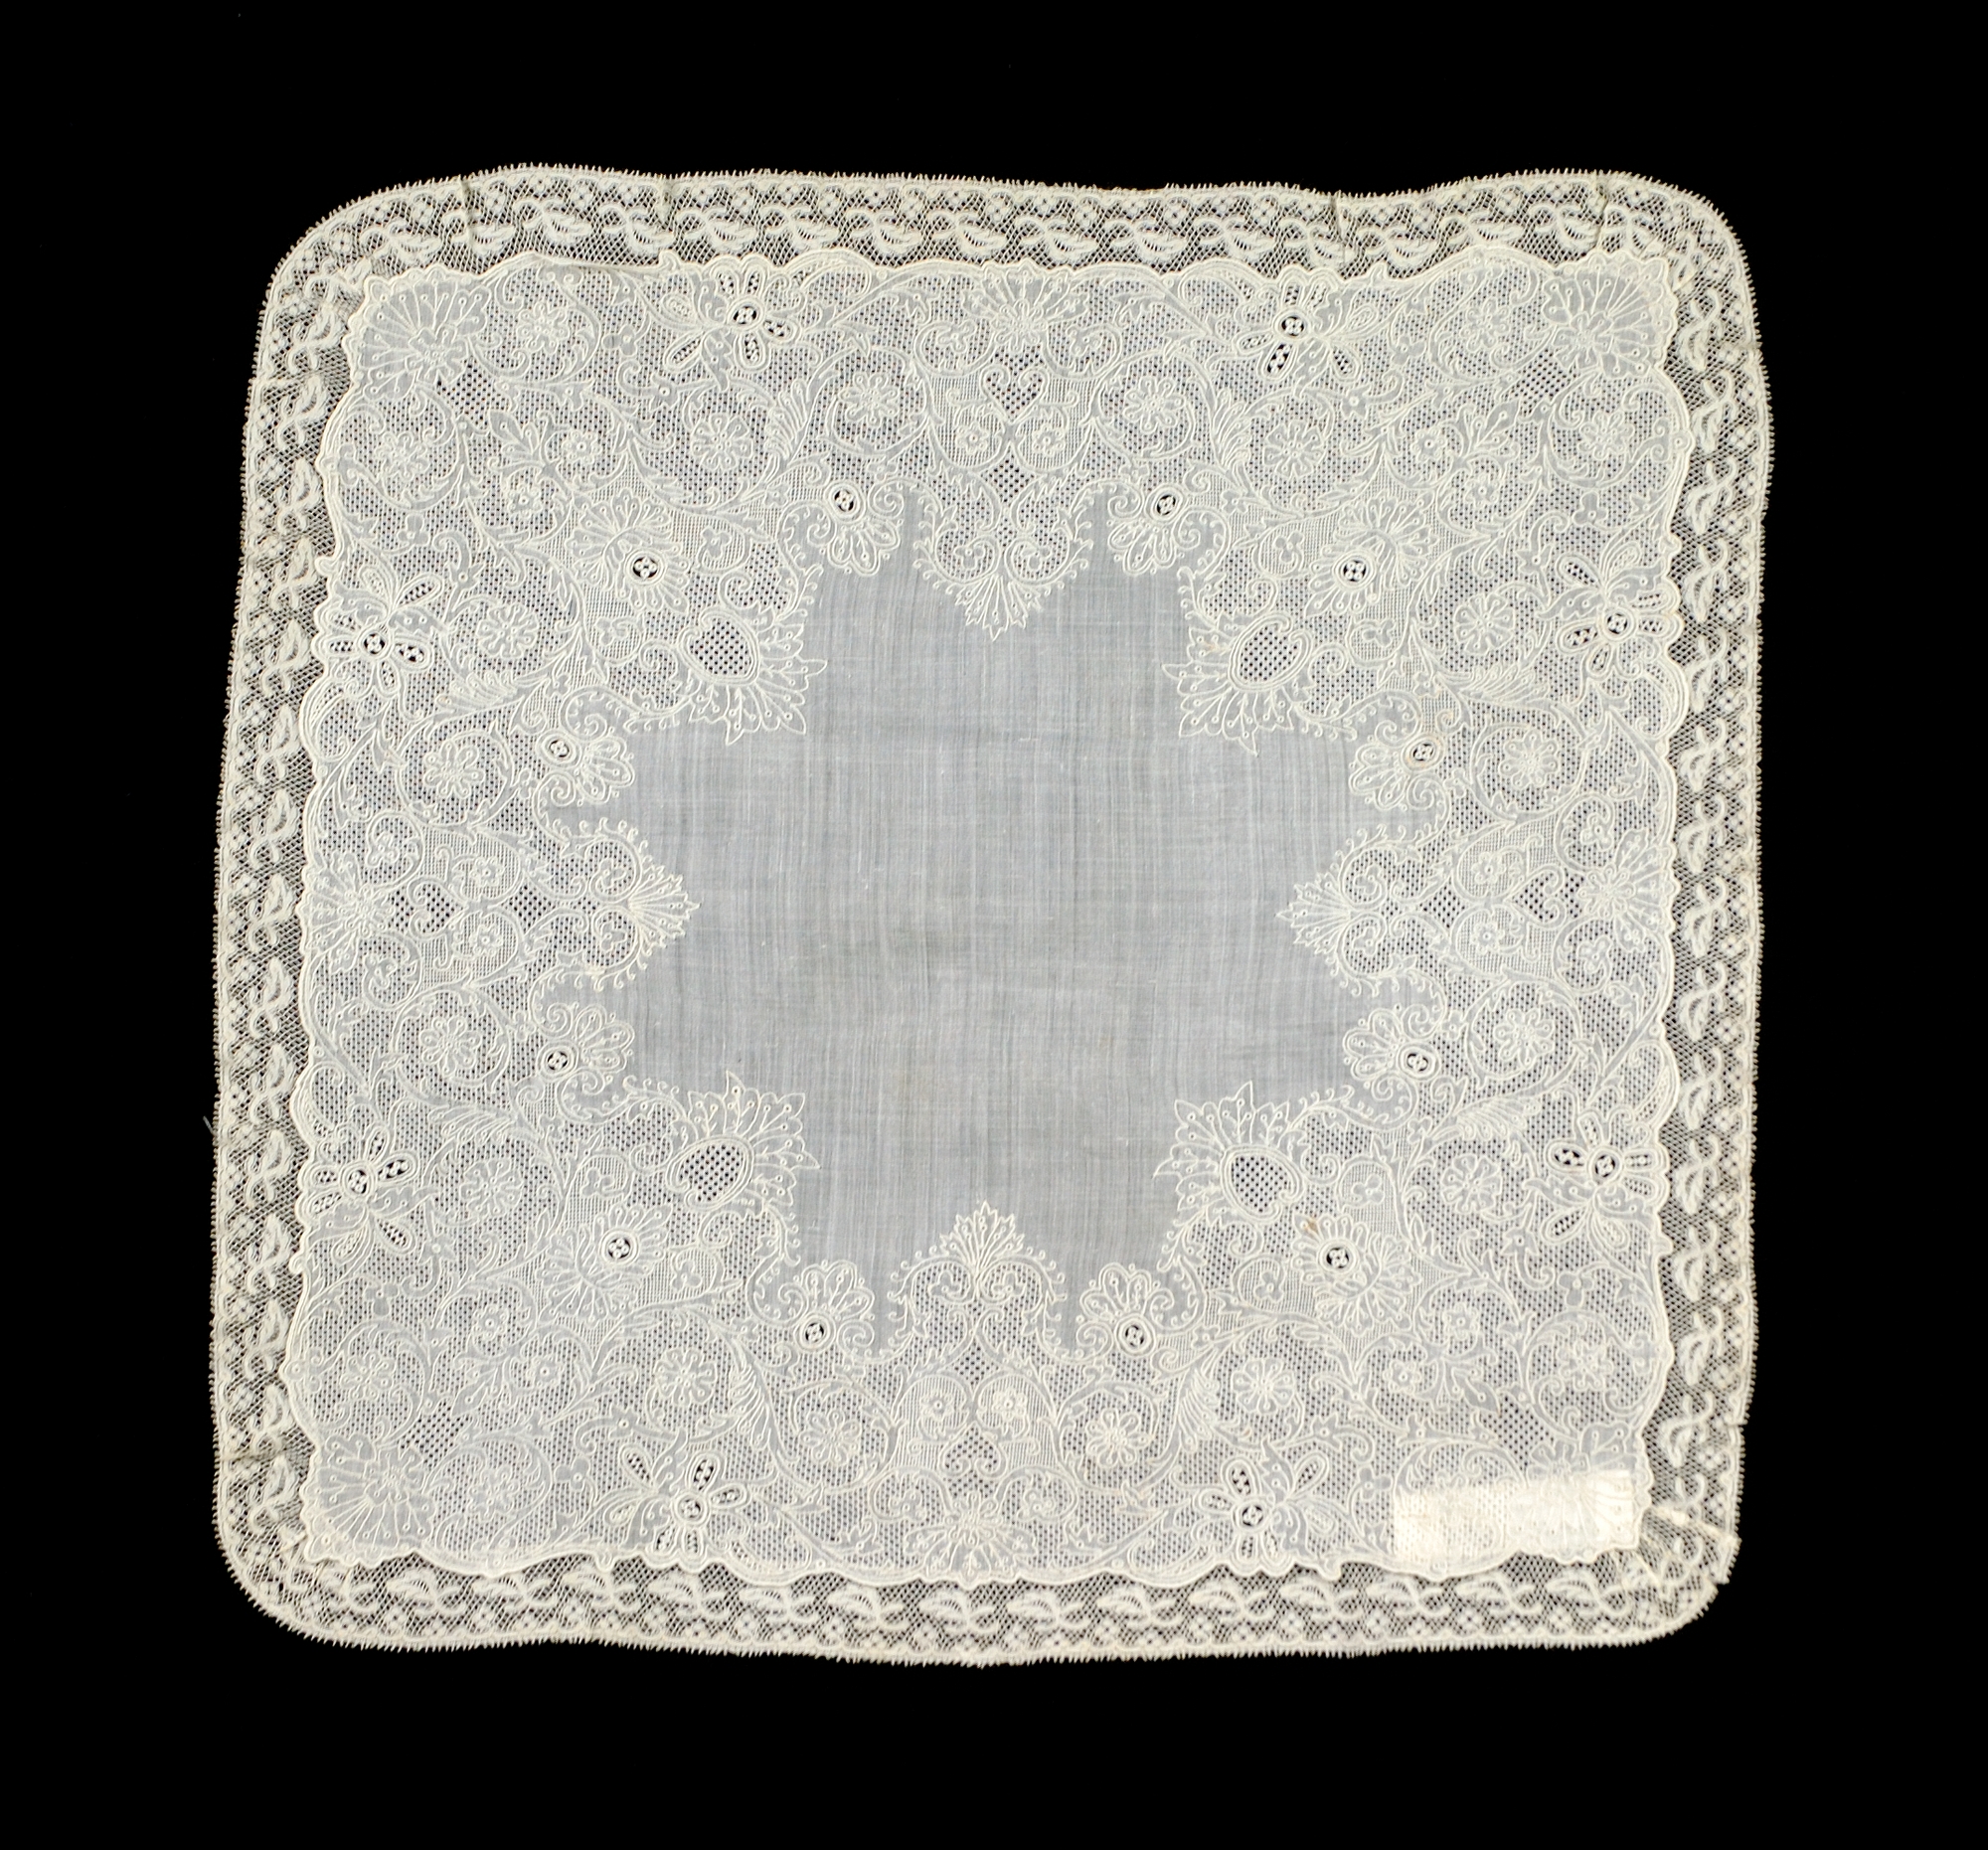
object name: handkerchief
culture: french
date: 1876-1900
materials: cotton